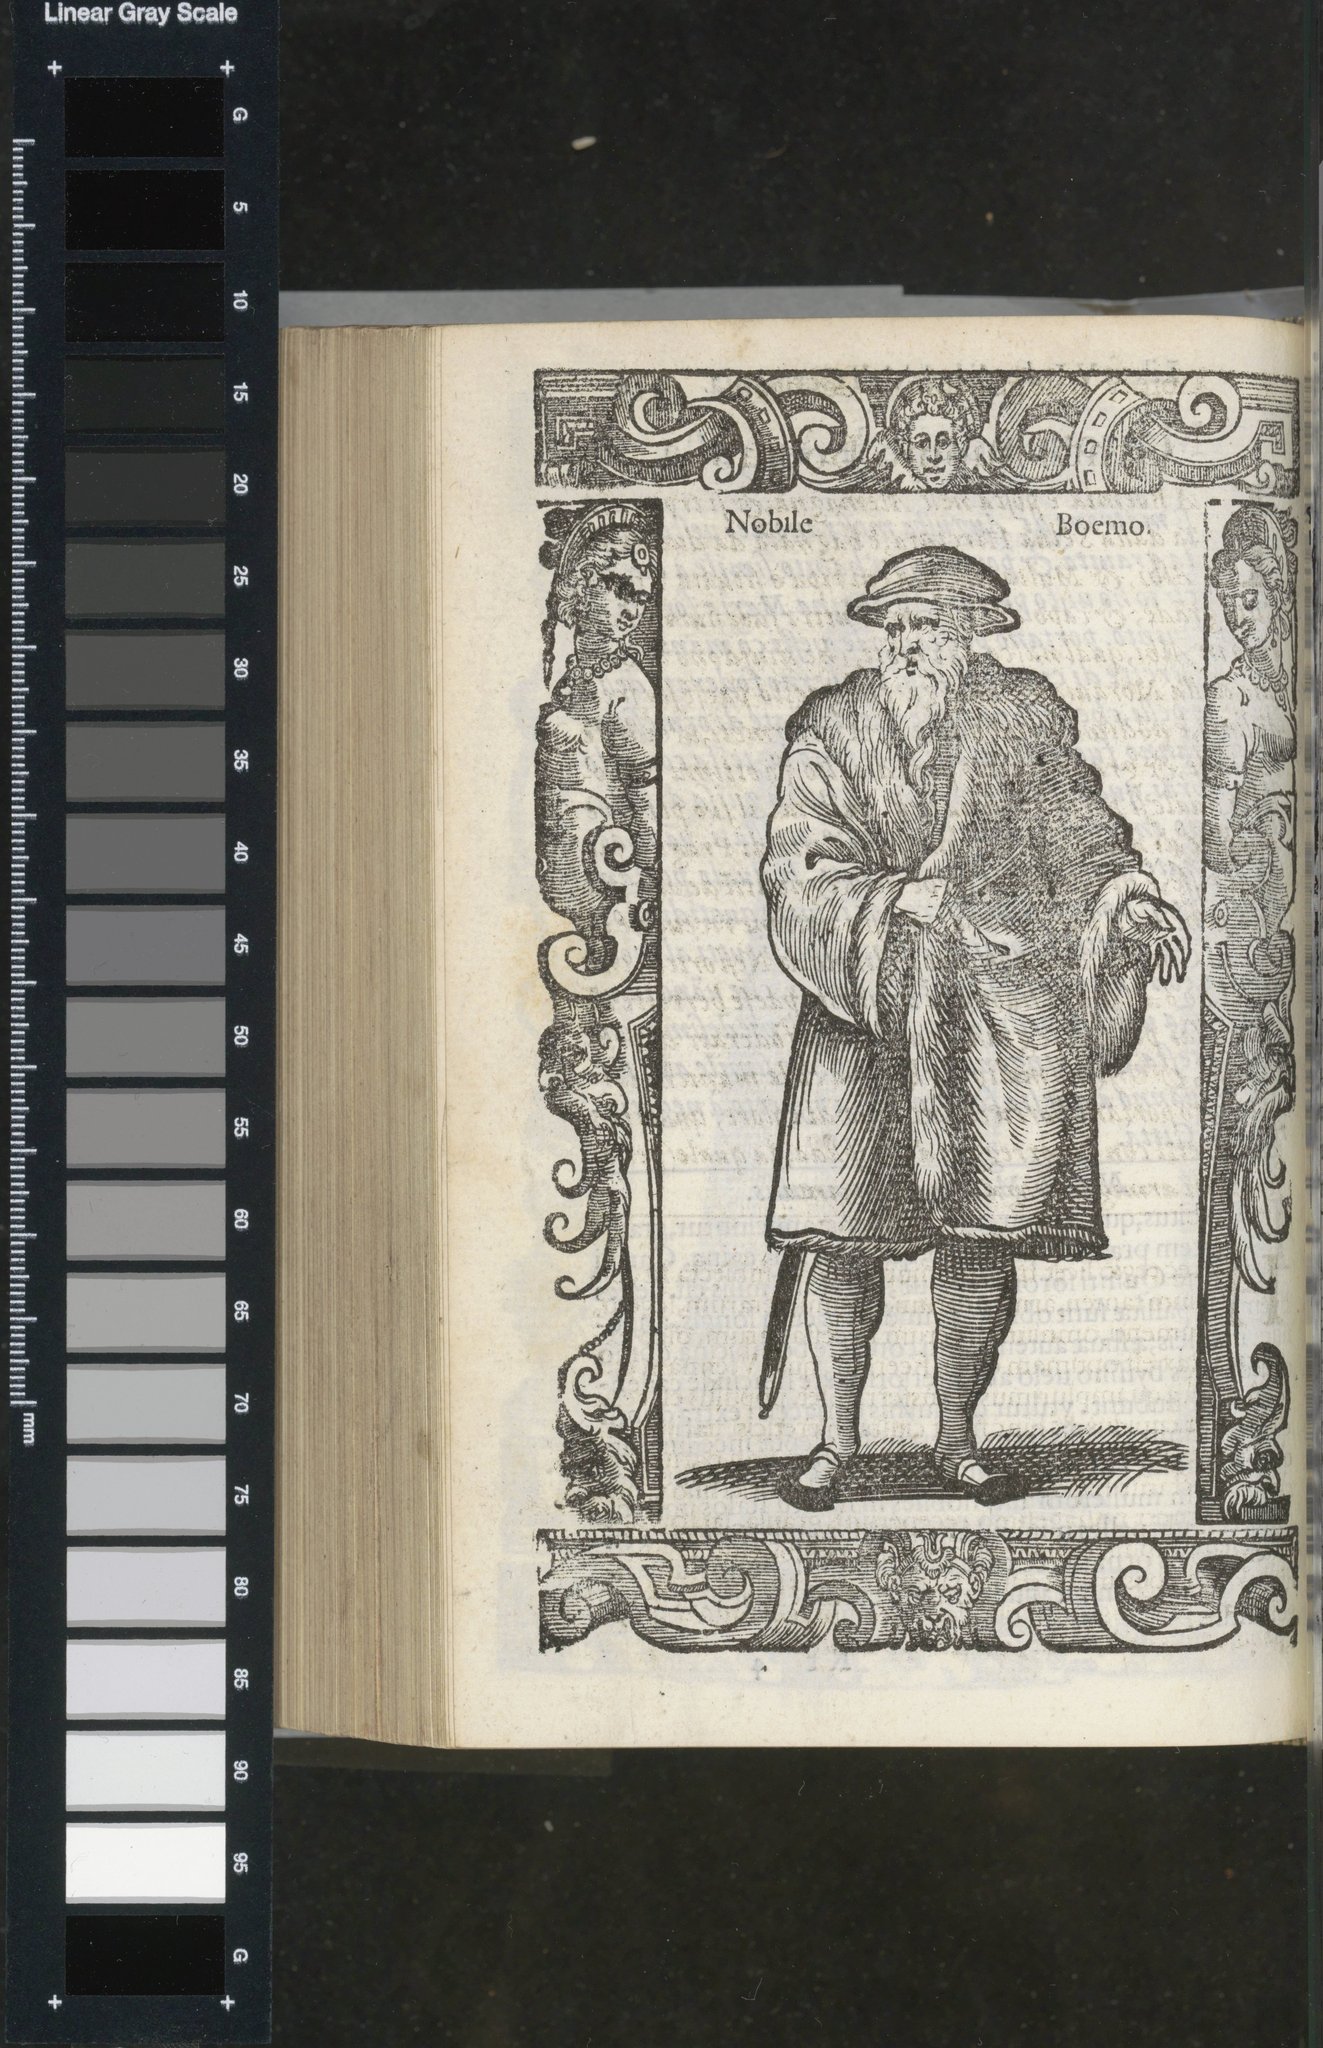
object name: costume print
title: Habiti antichi, et moderni di tutto il mondo...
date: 1598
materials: paper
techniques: woodcut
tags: fashion plates